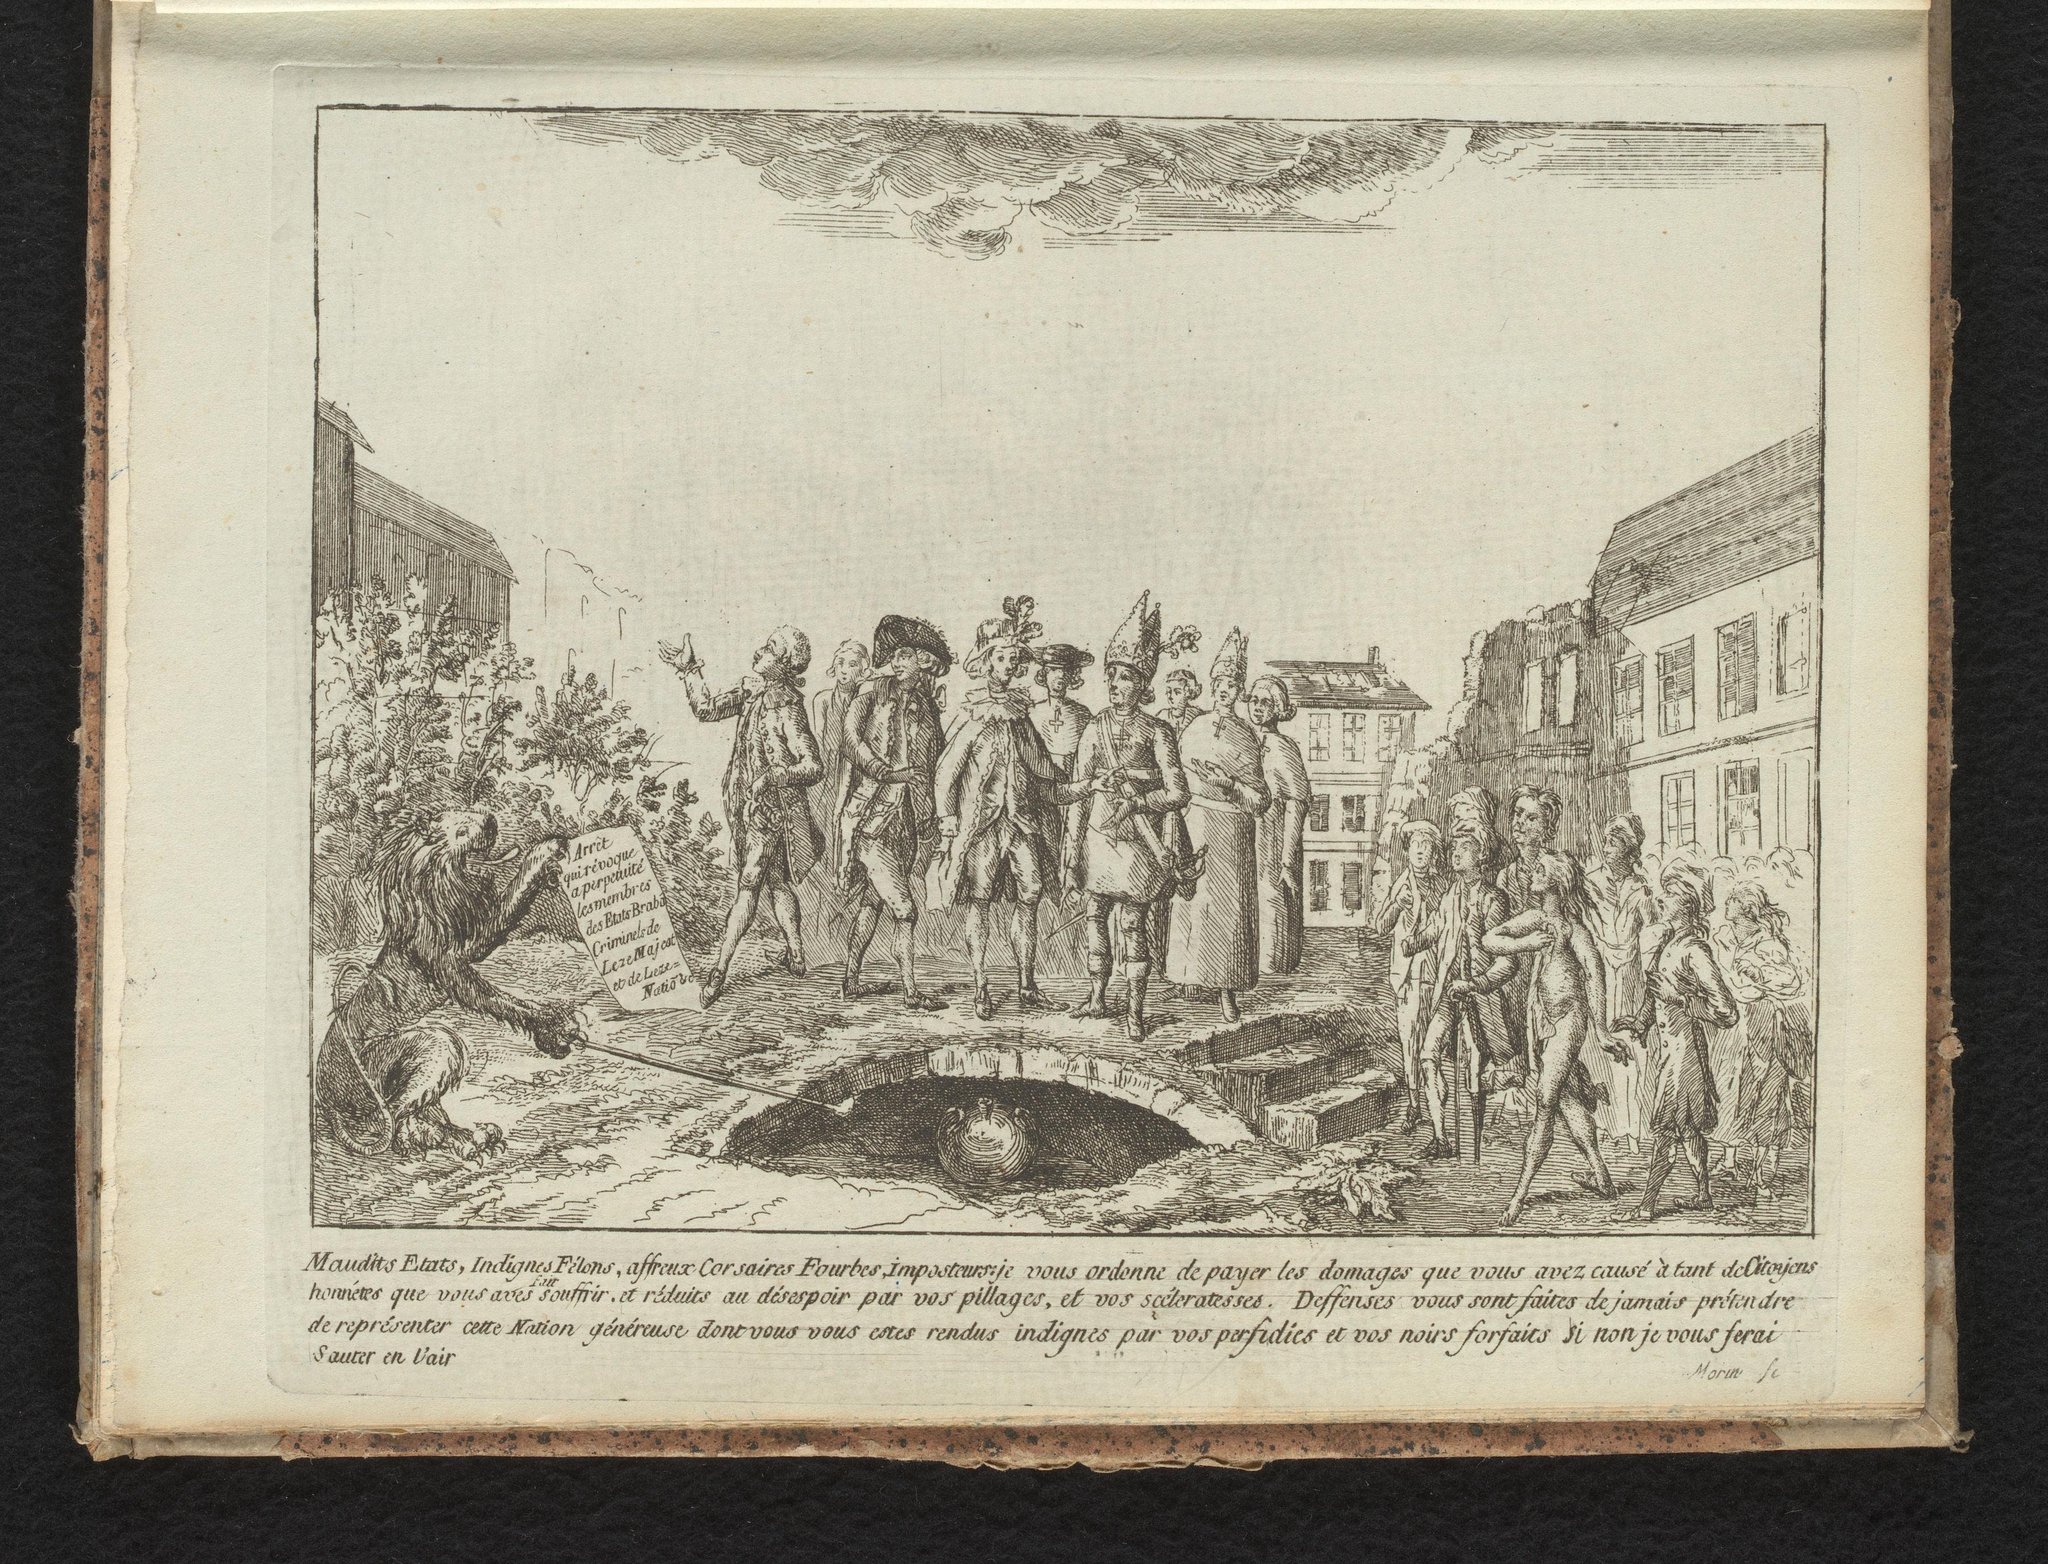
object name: cartoon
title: Maudits Etats, Indinges Fétons (...)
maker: morin (1791)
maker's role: print maker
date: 1787-1791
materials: paper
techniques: engraving, etching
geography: southern netherlands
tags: bomb-outrage, brabant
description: De Brabantse leeuw ontsteekt een bom onder een brug waarop de karikaturale leden van de Staten van Brabant staan. Rechts arme en berooide omstanders. Met Frans onderschrift van vier regels. Onderdeel van de gebundelde verzameling prenten betrekking hebbend op de gebeurtenissen van de Brabantse Omwenteling en de periode 1787-1790.